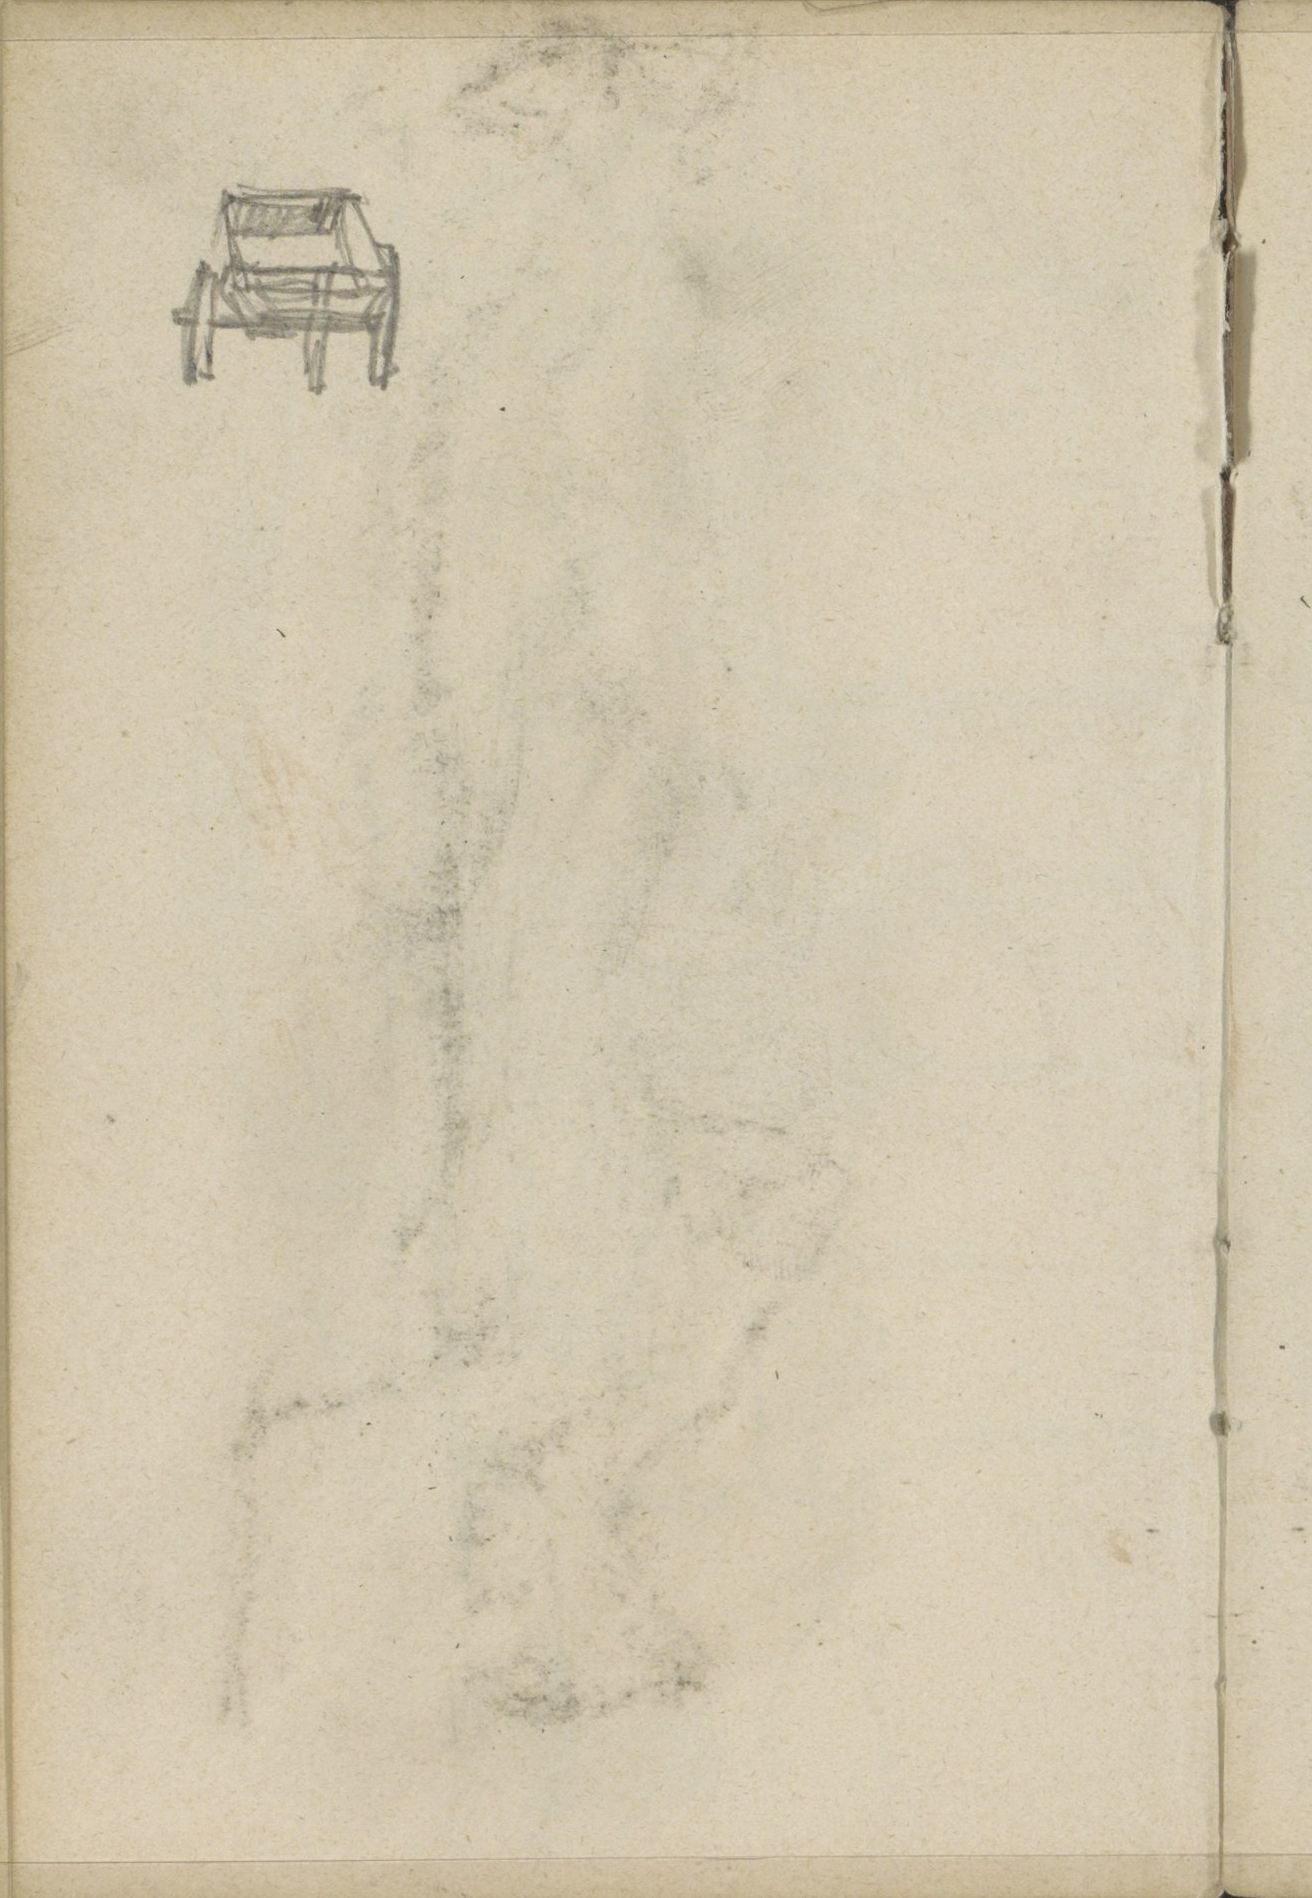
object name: sketchbook leaf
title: Studie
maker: george hendrik breitner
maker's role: draughtsman, painter, print maker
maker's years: 1857-1923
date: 1906-1923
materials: paper, pencil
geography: amsterdam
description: Studie. Pagina 73 uit een schetsboek met 46 bladen vervaardigd in Amsterdam en Haarlem.